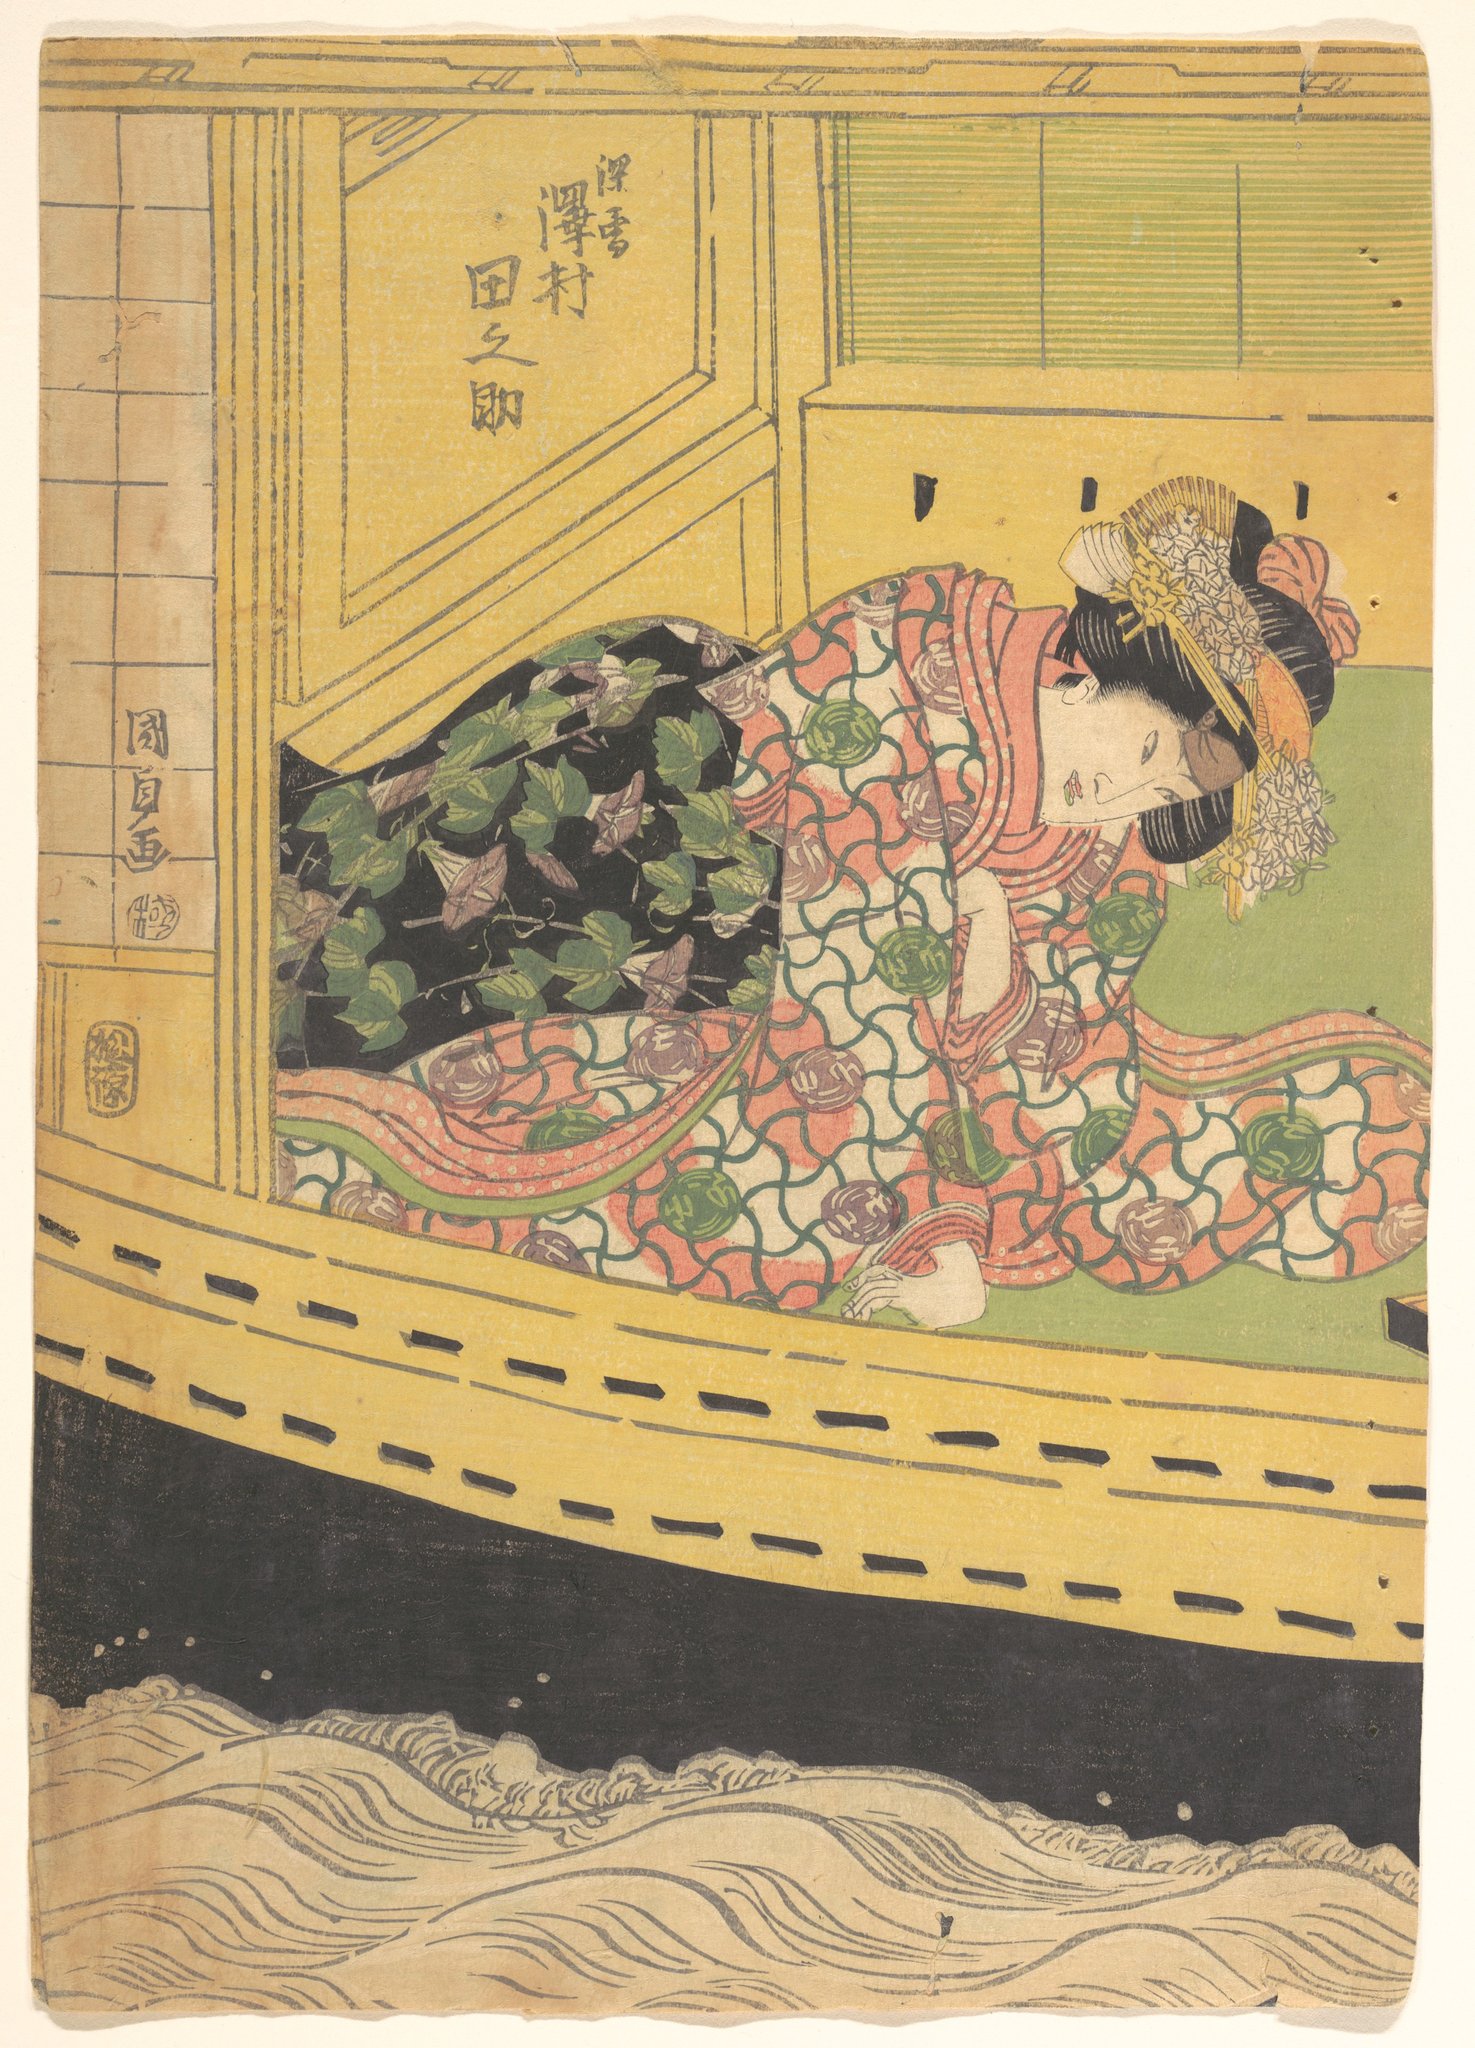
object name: print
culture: japanese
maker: utagawa kunisada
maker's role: artist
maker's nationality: japanese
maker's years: 1786-1864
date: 1801-1900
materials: ink, paper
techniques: woodblock print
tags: women,waves